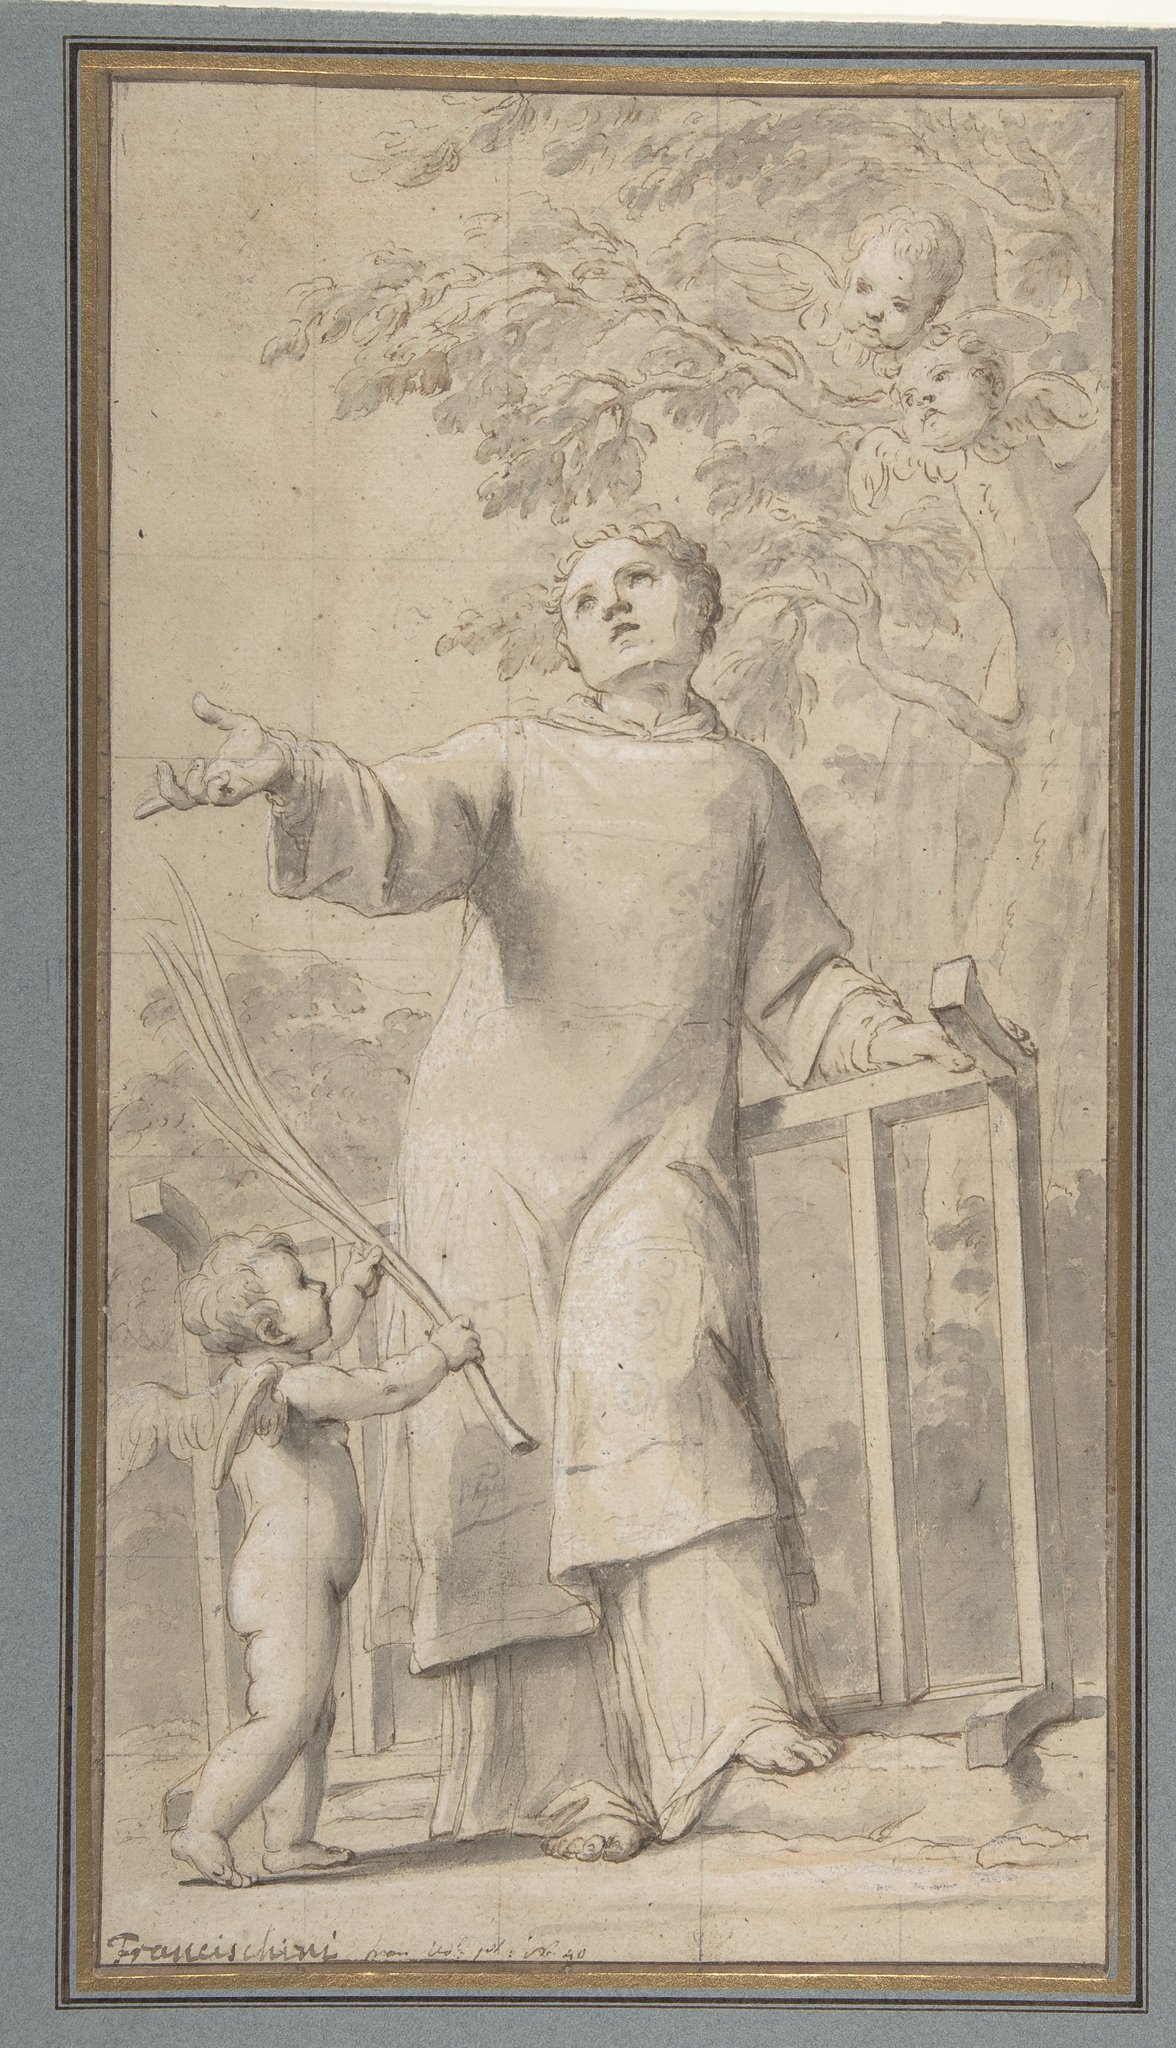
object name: drawing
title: Saint Lawrence Standing and Holding the Grill, Instrument of His Martyrdom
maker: marcantonio franceschini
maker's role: artist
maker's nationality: italian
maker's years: 1648-1729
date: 1715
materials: chalk, ink, paper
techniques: brush, highlighting, pen, drawing, wash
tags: trees,angels,saint lawrence